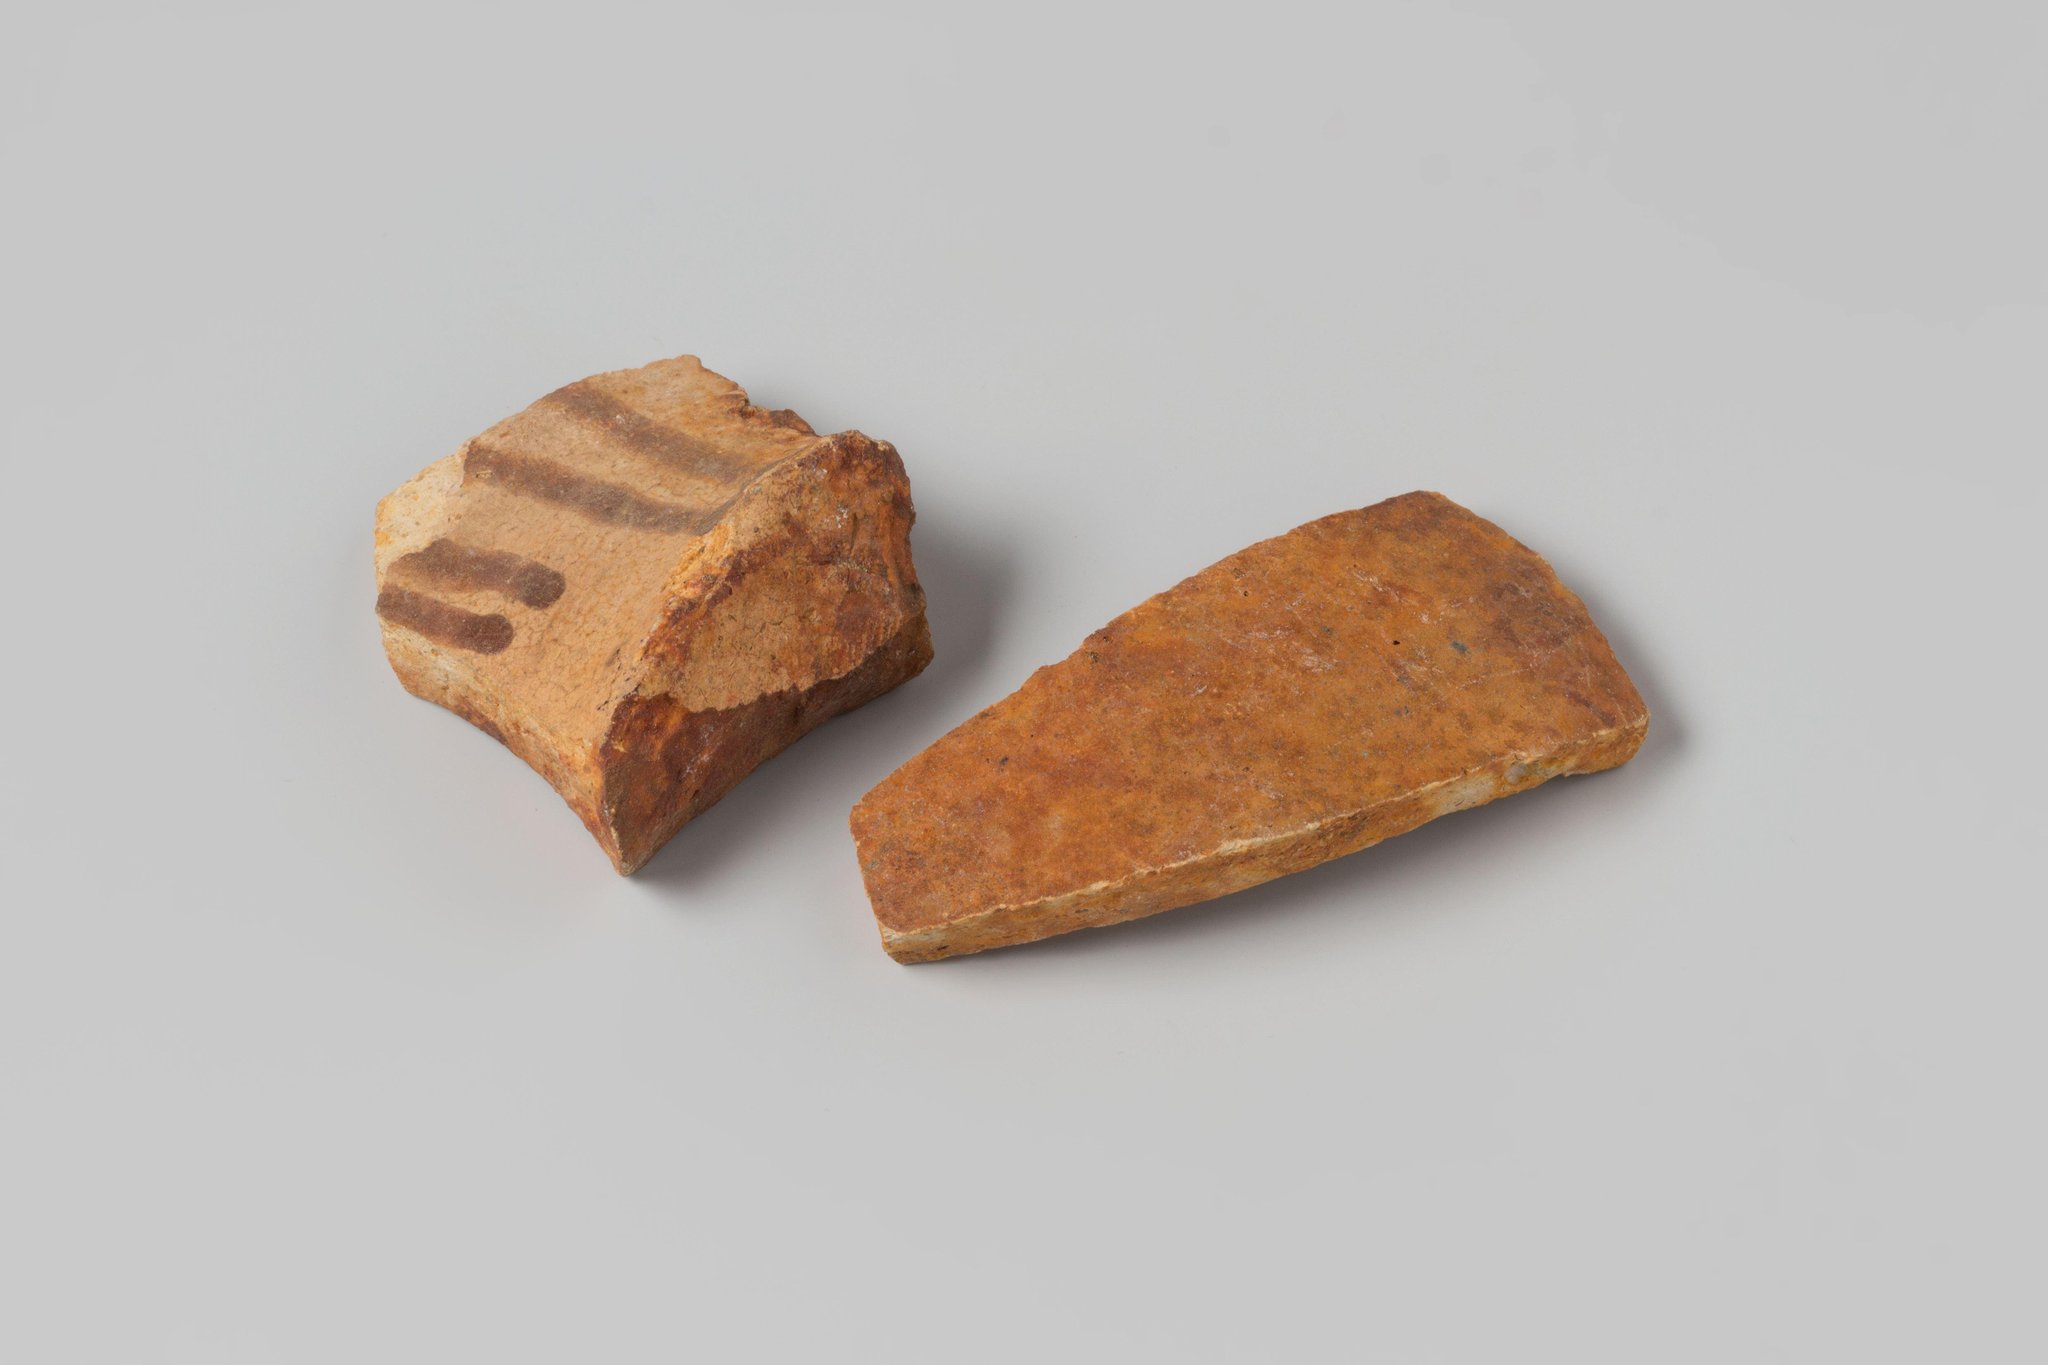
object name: ewer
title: Scherven van kannen uit het wrak van de Oost-Indiëvaarder Hollandia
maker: Anonymous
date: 1700-1743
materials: stoneware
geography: cologne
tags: verenigde oostindische compagnie, hollandia (schip), annet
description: Stoneware, Rhenish, Frechen-ware, jug; fragm of base, sim. NG 1980-27H1842, fragm of body.